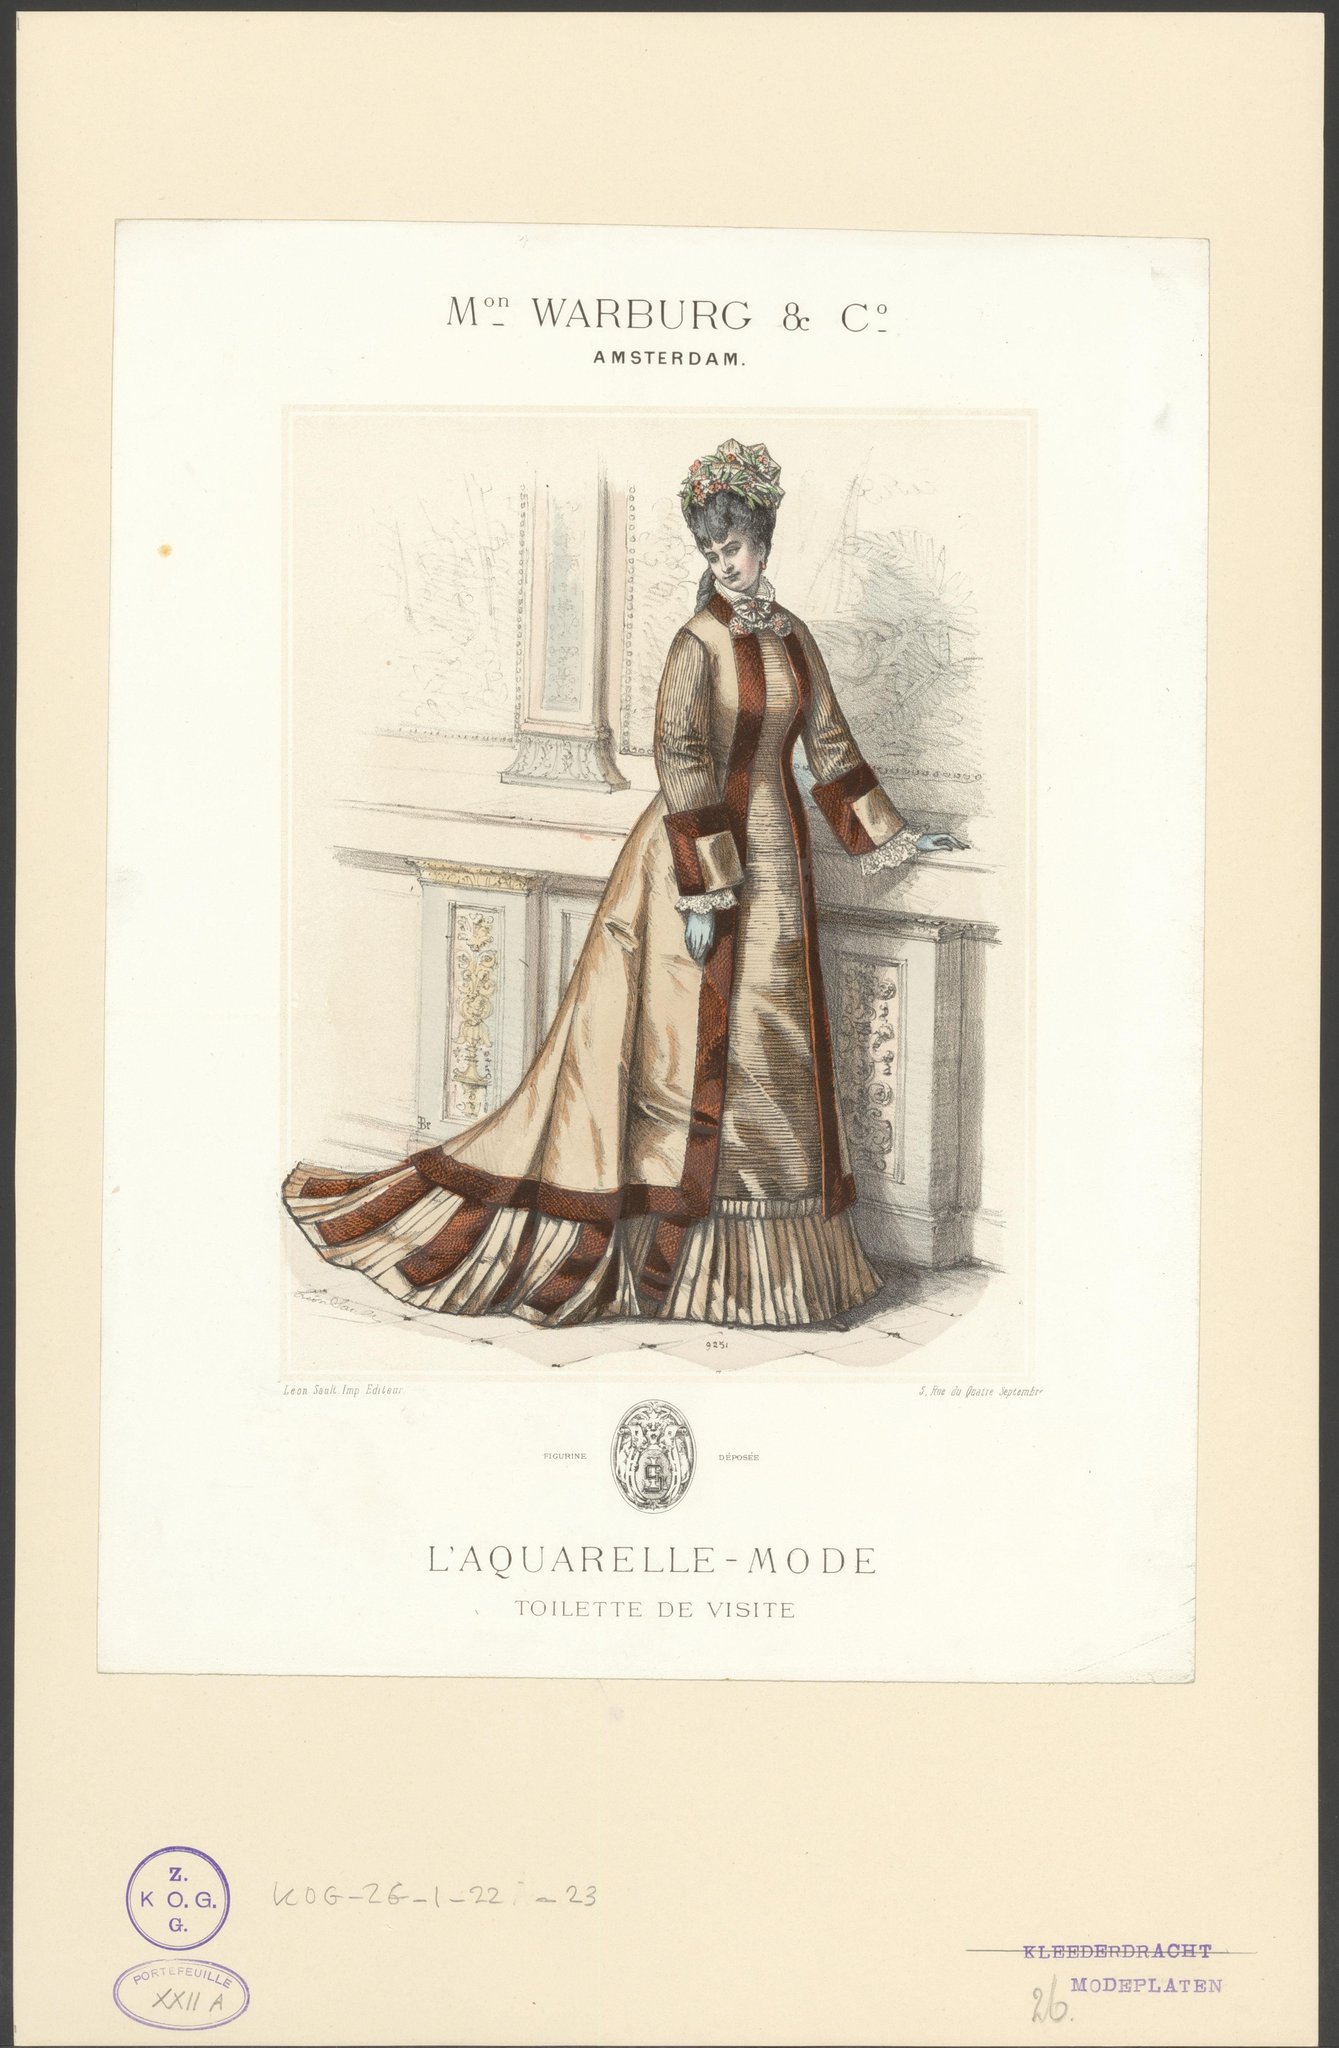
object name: print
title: Toilette de Visite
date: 1875-1886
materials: lacquer, paper, watercolor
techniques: hand coloring, lacquer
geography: paris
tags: fashion plates, clothes, costume (+ women's clothes), dress, gown (+ women's clothes)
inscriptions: collector's mark, collector's mark: Lugt 1641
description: Vrouw in bruine en gouden japon, staande naar rechts, de hand op de muur. Met vermelding van 'Mon. Warburg & Co. Amsterdam'. Prent uit het modetijdschrift L'Aquarelle-Mode (1866-1892). nr. 9251. Onderwerpsrubrieken binnen de Atlas Zeden en Gewoonten: De Kleeding, Modeplaten.